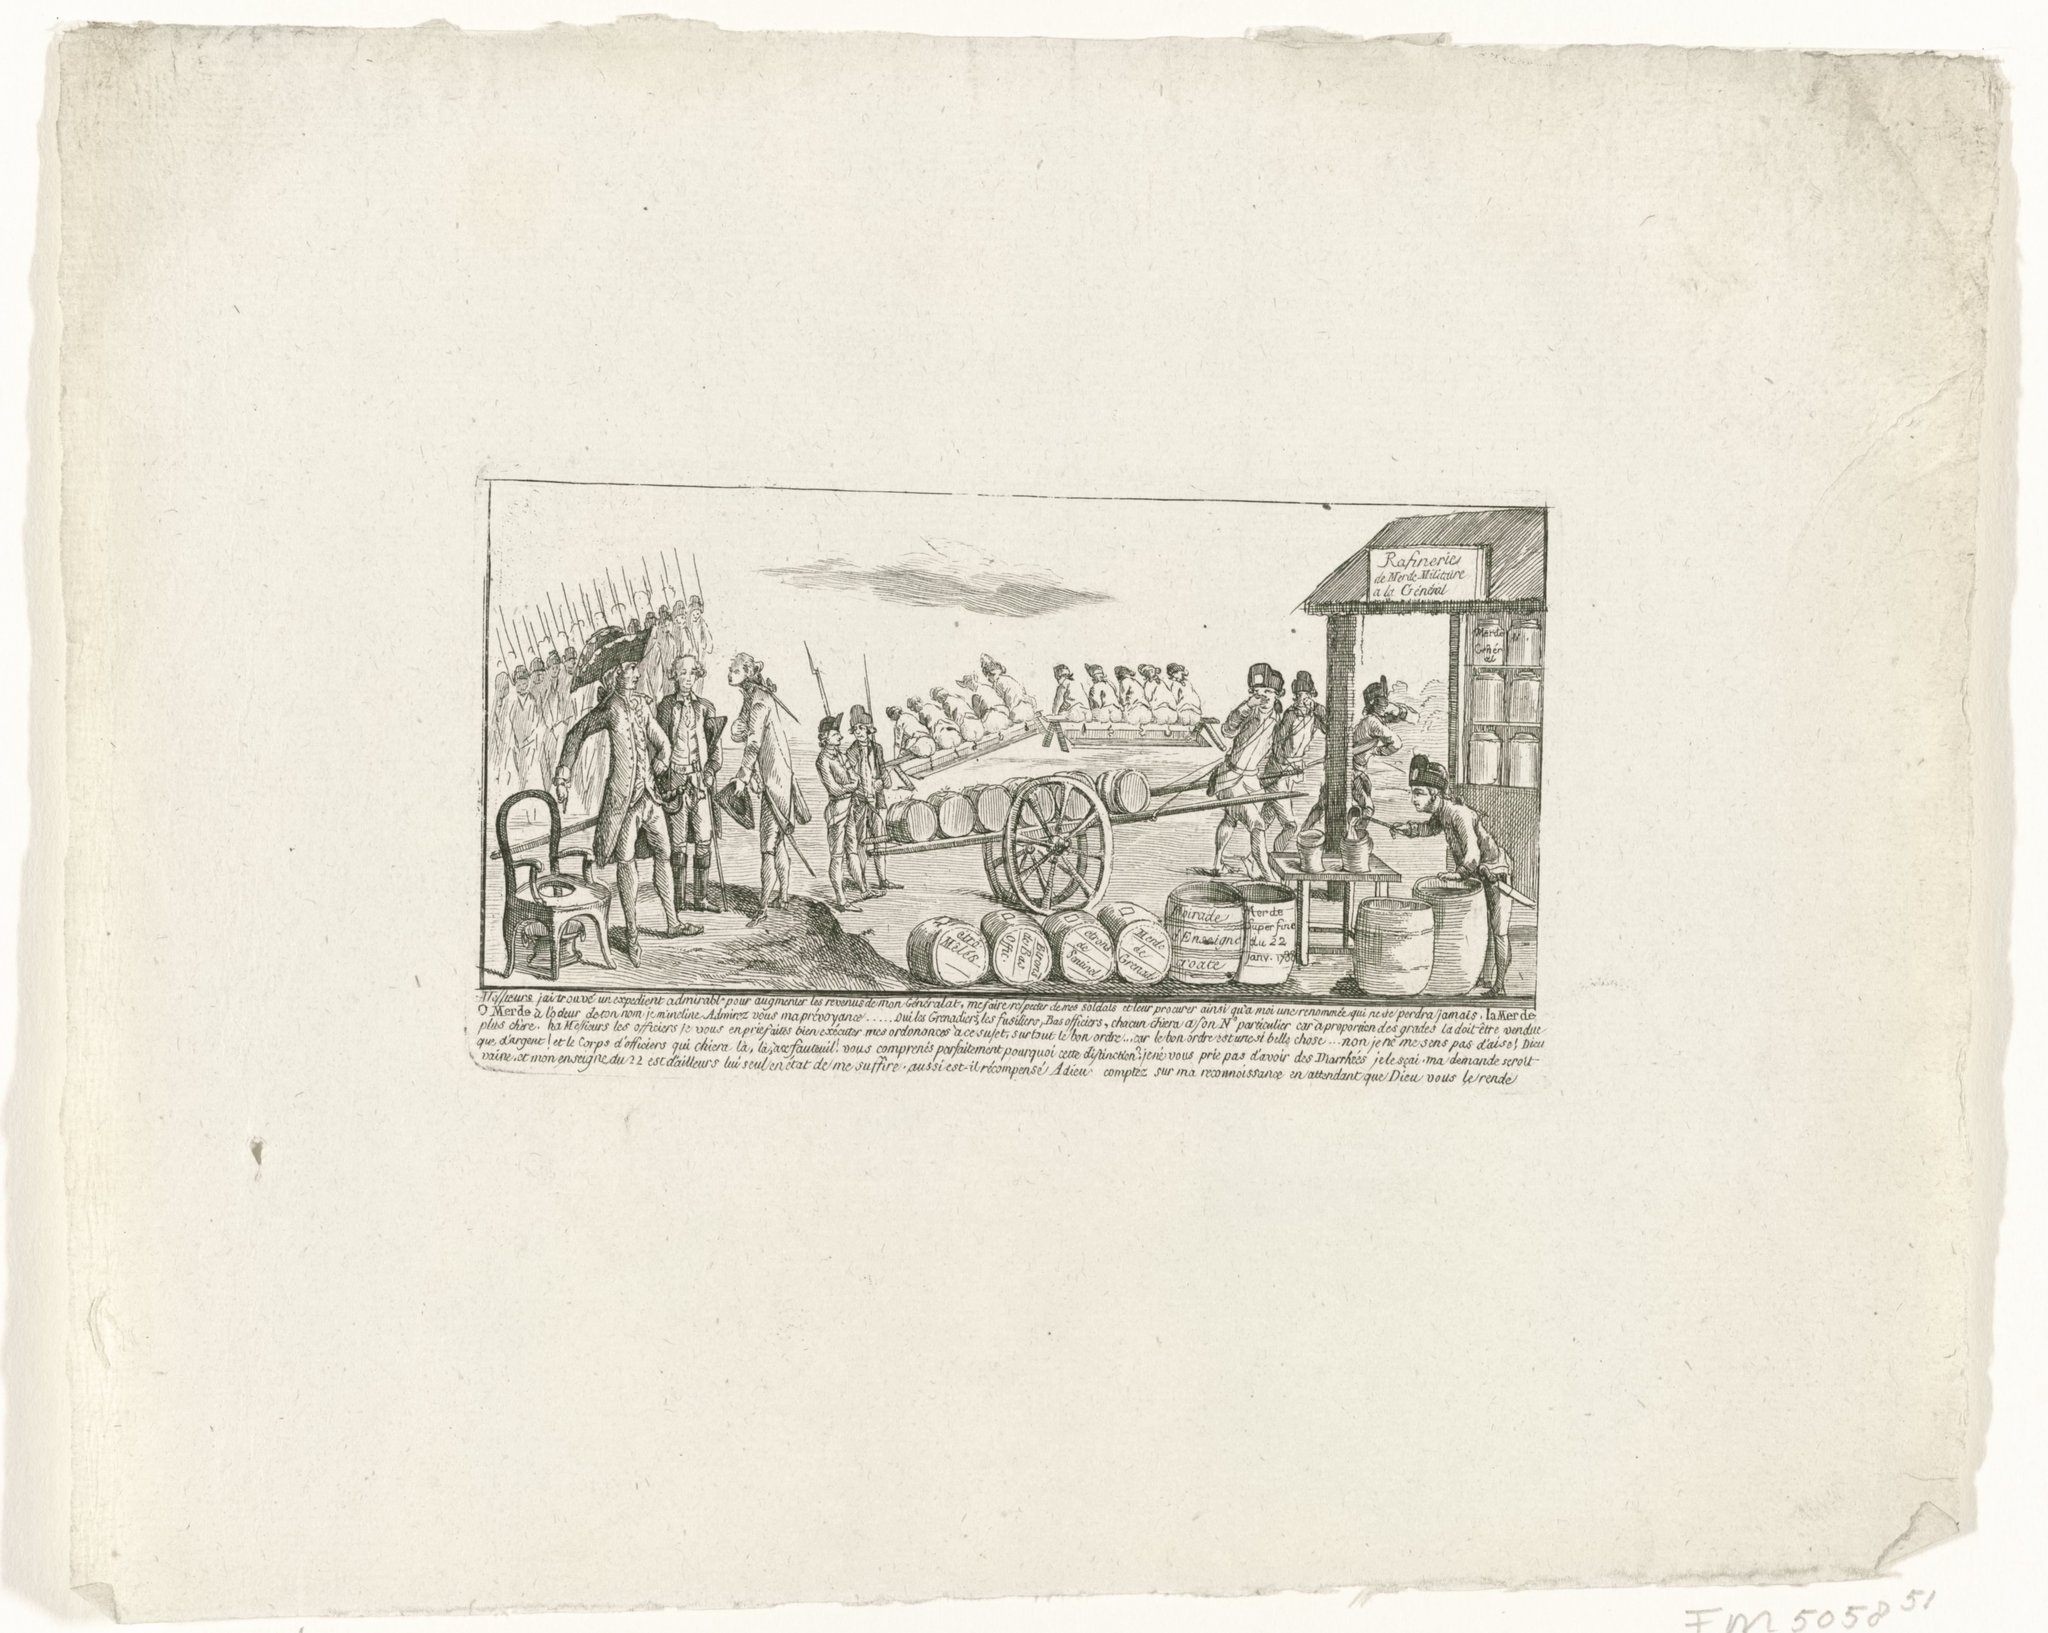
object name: print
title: Brabantse Omwenteling, 1787-1790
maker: Anonymous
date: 1787-1790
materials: paper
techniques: engraving, etching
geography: southern netherlands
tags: defecation, brussels, brabant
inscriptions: collector's mark: Lugt 2228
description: Spotprent op de Oostenrijkse generaal d'Alton. De uitwerpselen van Oostenrijkse soldaten worden opgevangen en in tonnen bewaard. Links de generaal bij een kakstoel. Ook in verband met de schietpartij te Brussel op 22 januari 1788. Met Frans onderschrift van 5 regels. Onderdeel van een grote groep van prenten betrekking hebbend op de gebeurtenissen van de Brabantse Omwenteling en de periode 1787-1790.